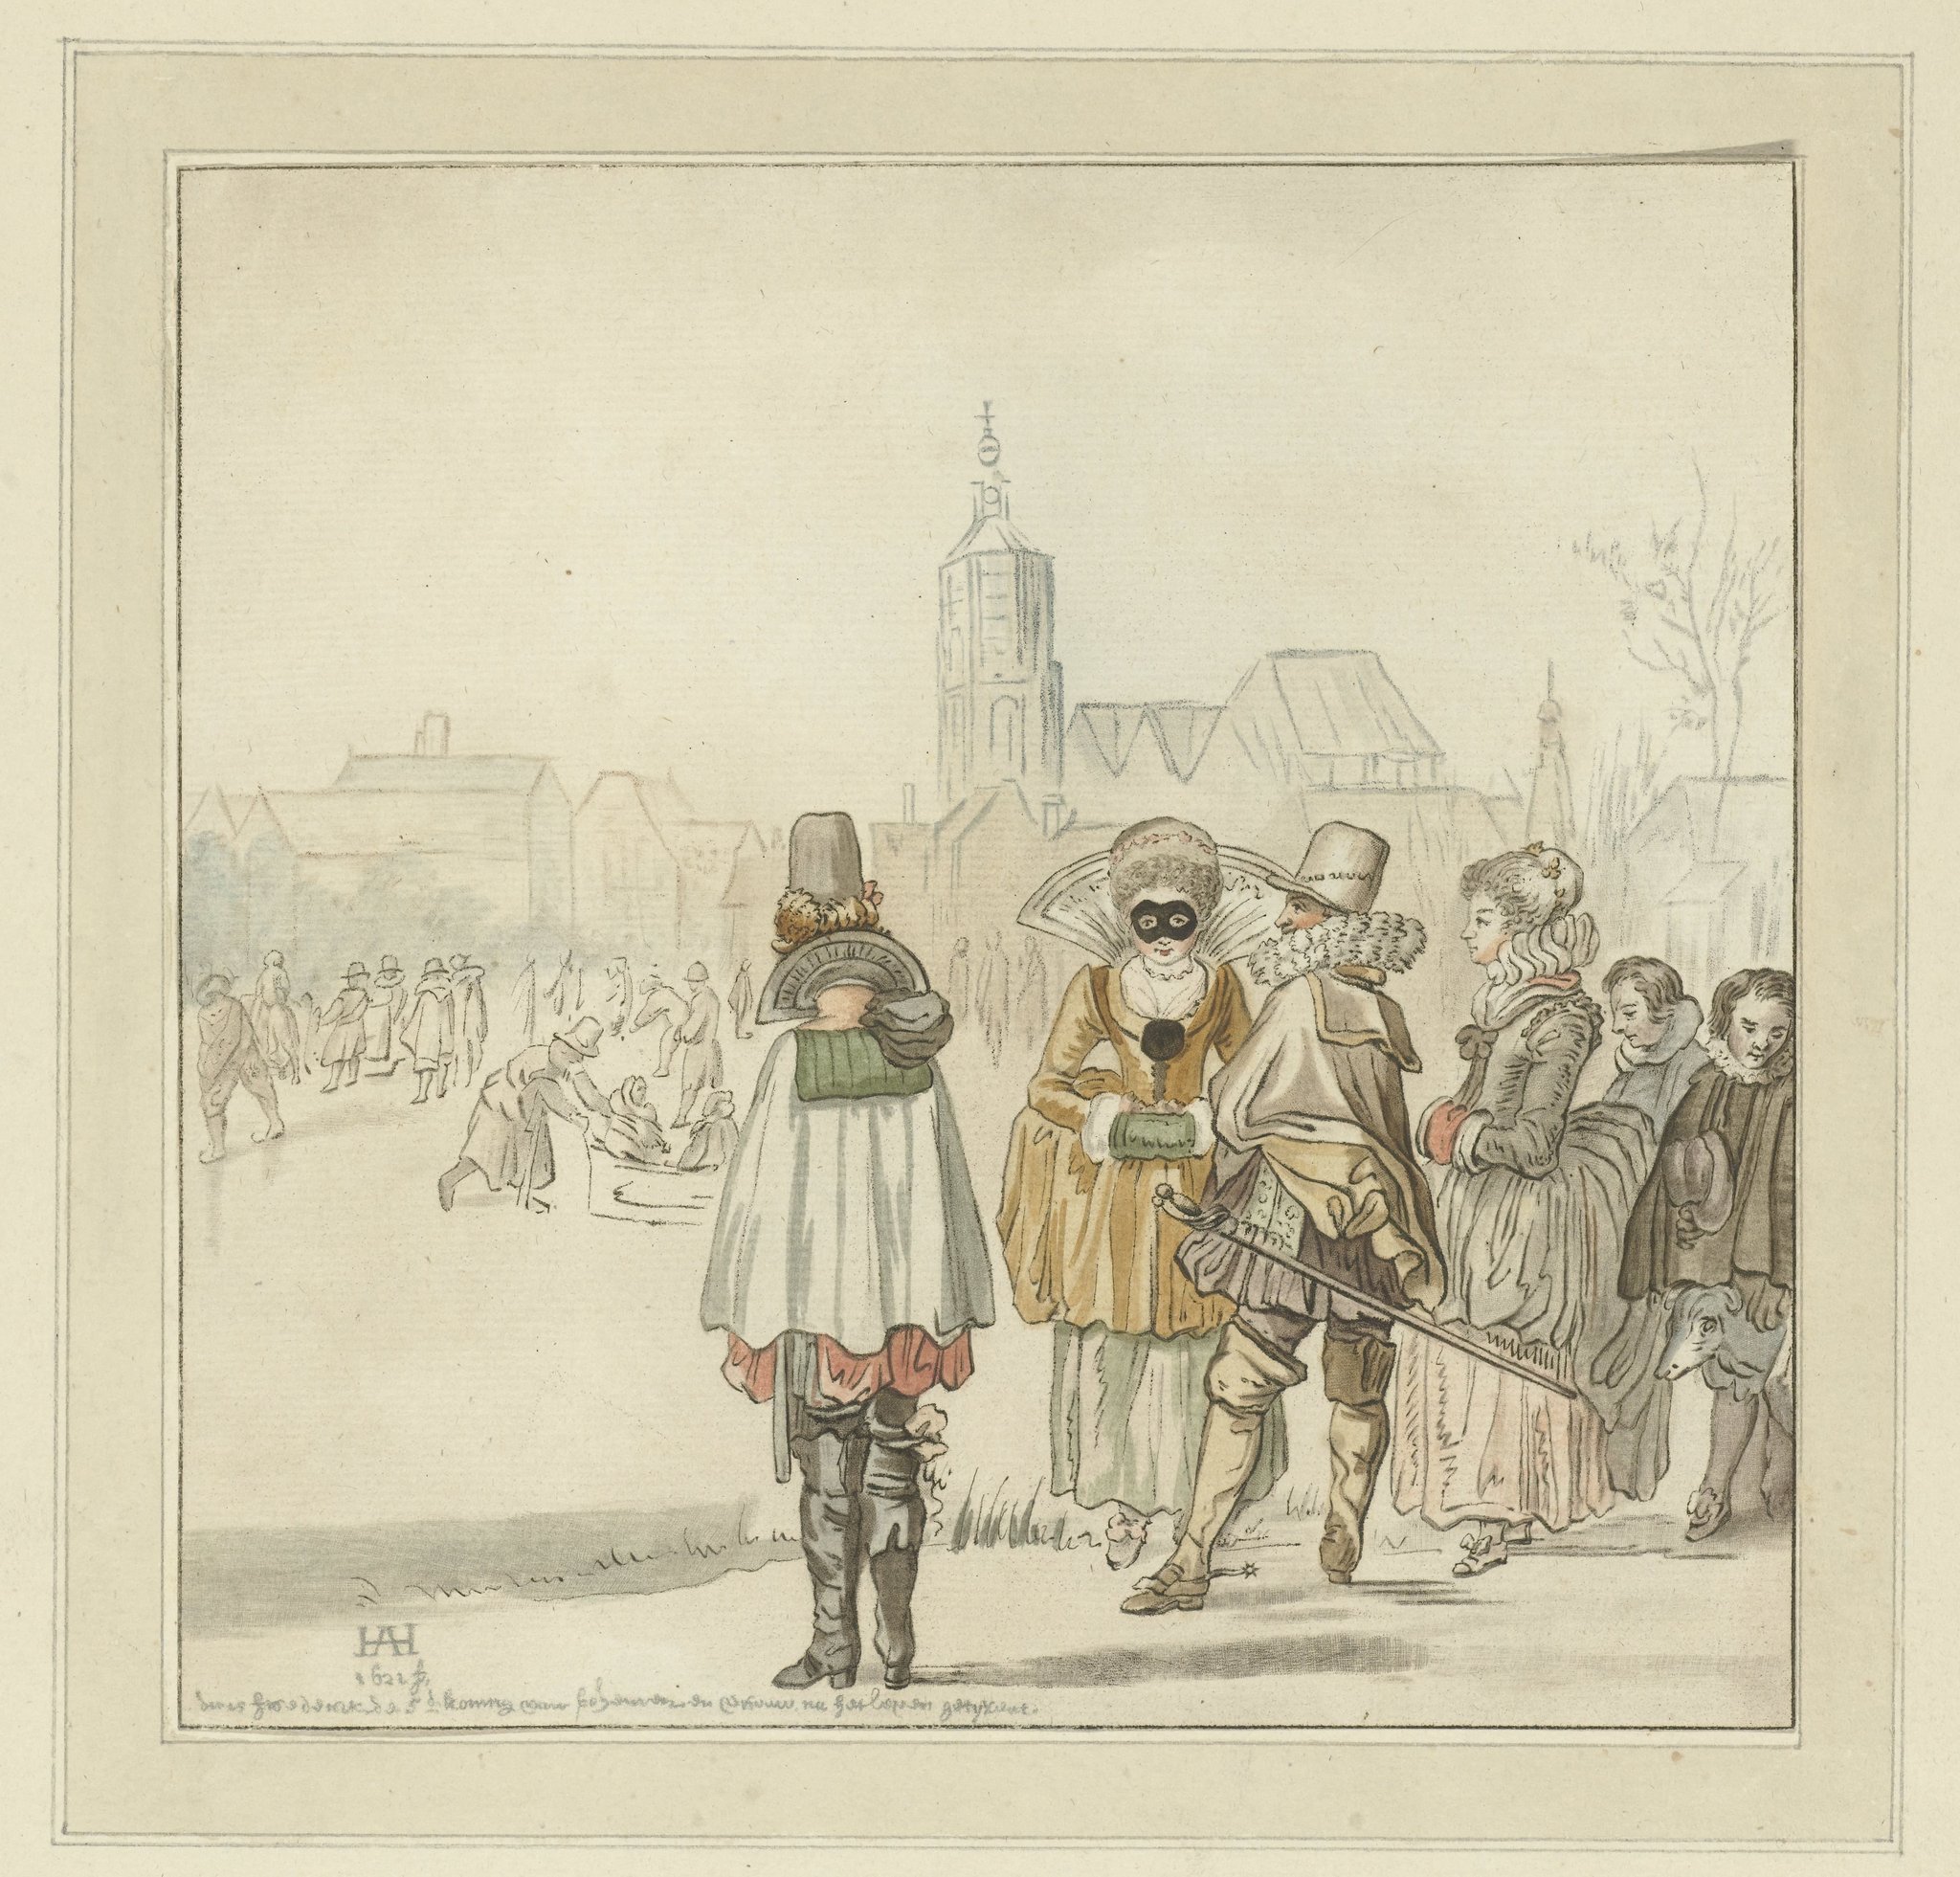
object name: print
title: De Winterkoning op het ijs, 1621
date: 1766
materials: paper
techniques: hand coloring, lithography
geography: netherlands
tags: amberg, frederik v (keurvorst van de palts, koning van bohemen), london, winter sports, the hague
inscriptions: workshop stamp, inscription: ‘Hendr.k Avercamp Gebynaamt de Stomme van Campe. des 1621. Ploos van Amstel f: 1766’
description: De Winterkoning Frederik van de Palts met zijn vrouw (met masker en mof) te Den Haag op het ijs, mogelijk op de Paviljoensgracht, winter 1621. De jonge vrouw en de twee jongens zijn waarschijnlijk niet de dochter en zonen, maar leden van zijn gevolg. Op de achtergrond het dorp met ijsvermaak.